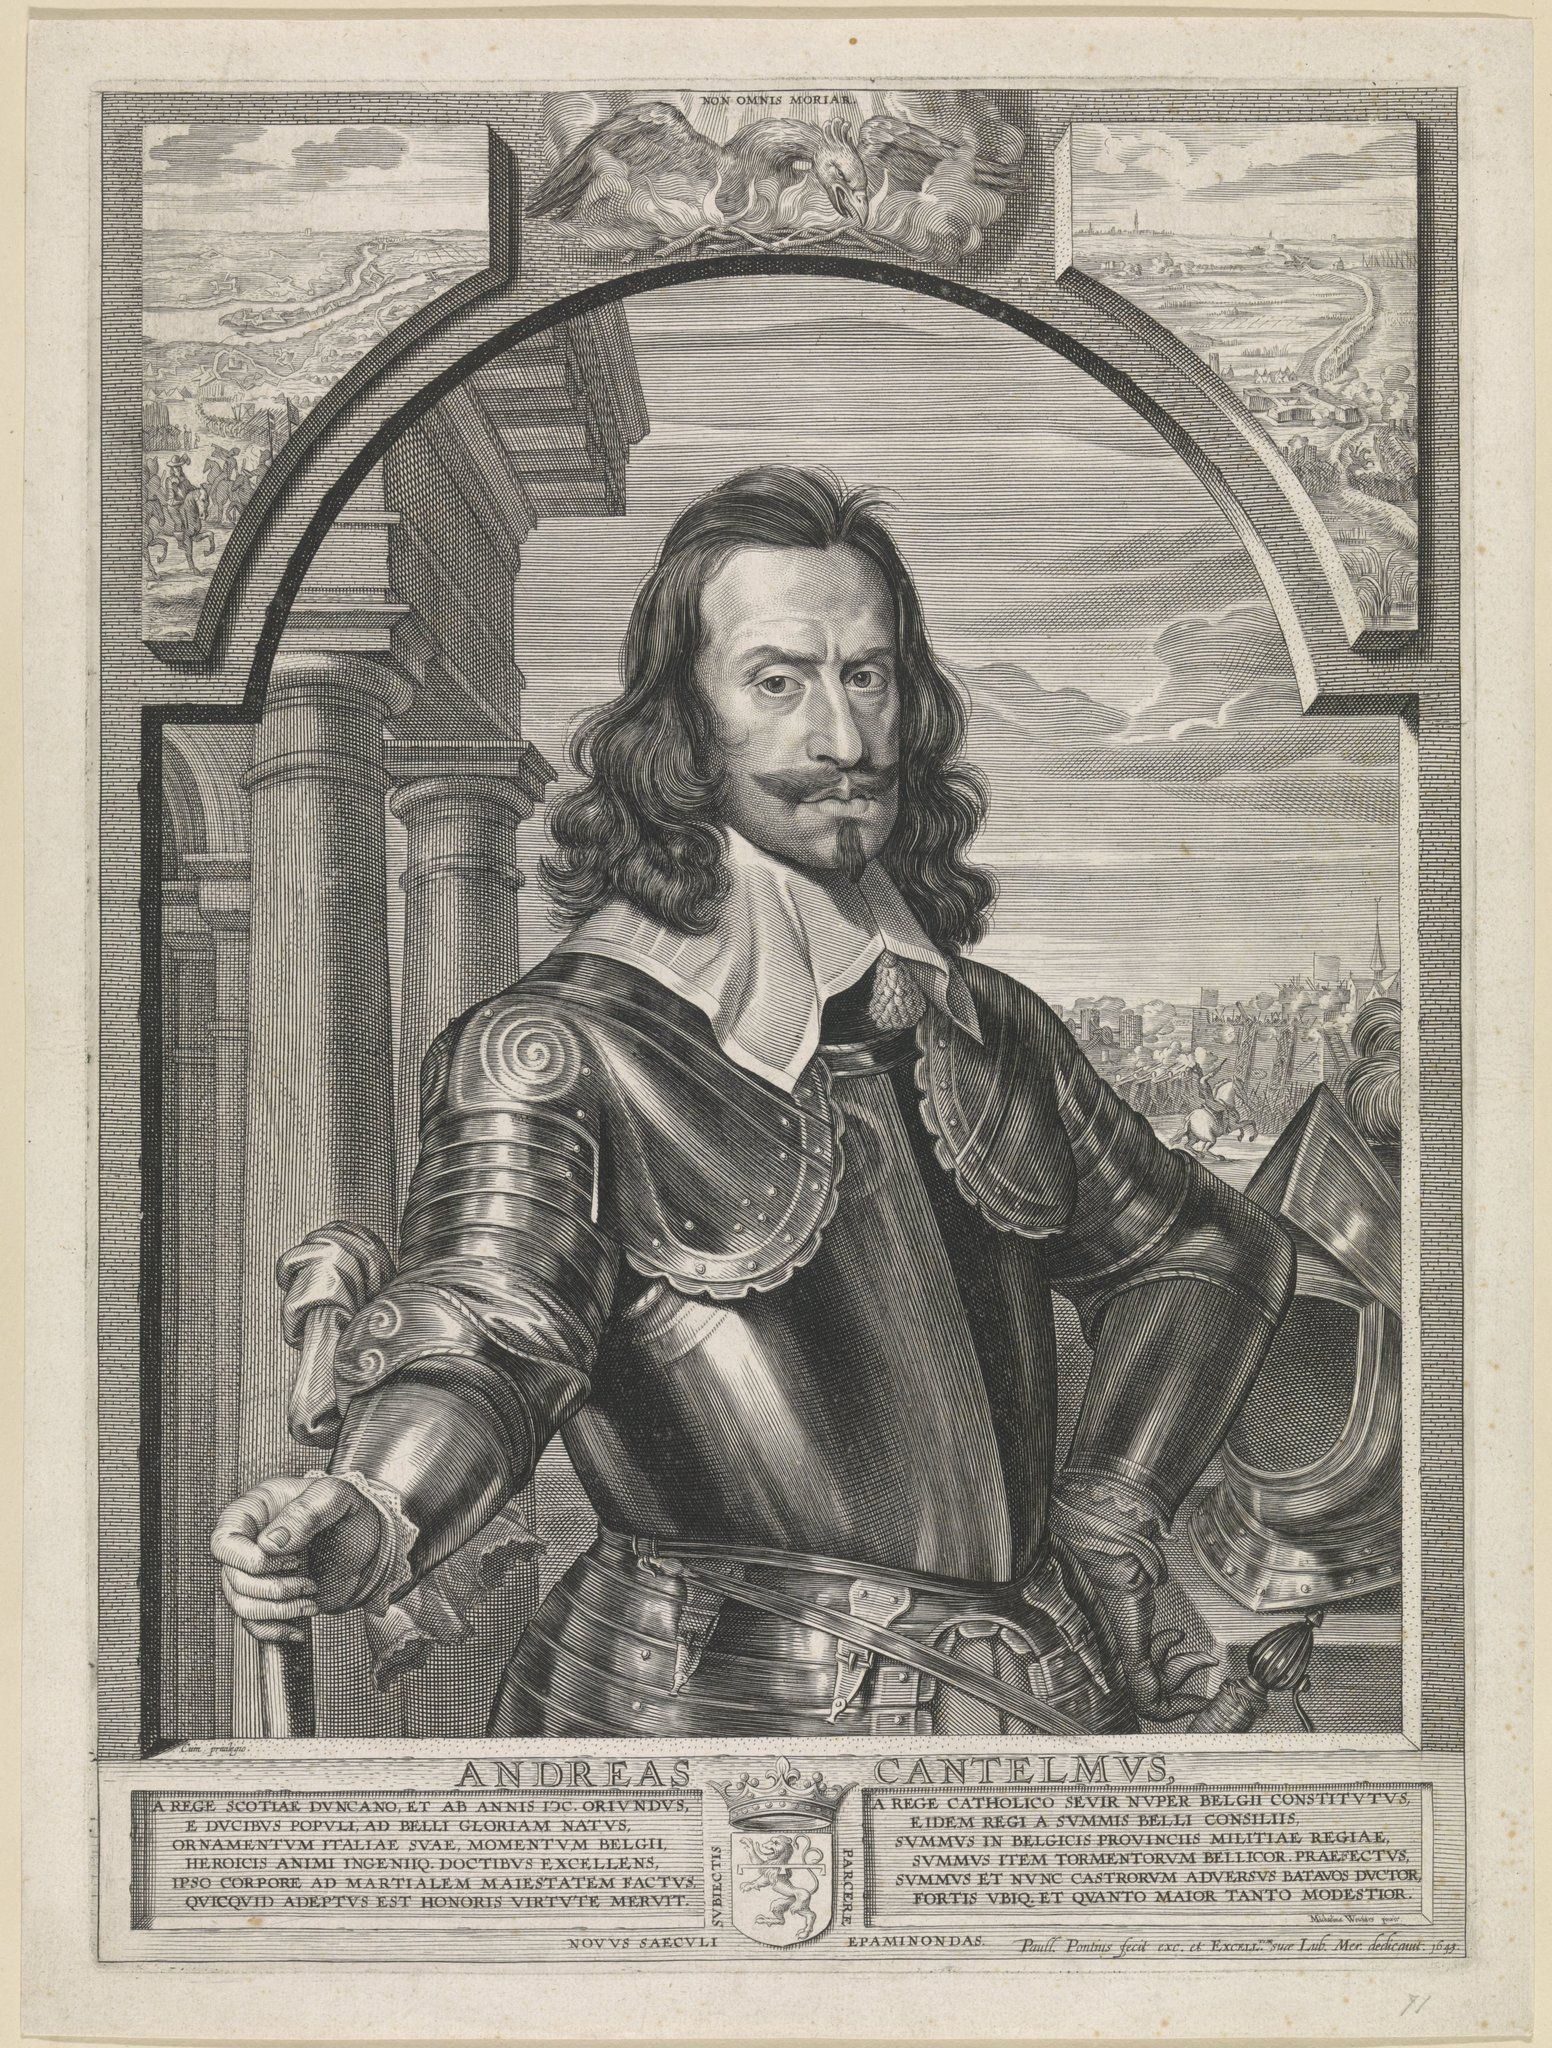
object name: print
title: Portret van Andrea Cantelmo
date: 1643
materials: paper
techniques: engraving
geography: antwerp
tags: don andrea cantelmo, predatory birds: eagle, armour, siege, armorial bearing, heraldry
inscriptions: inscription: ‘27 [...] E’, number: ‘120’, collector's mark: Lugt 240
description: Portret van de Italiaanse veldheer Andrea Cantelmo, hij was in dienst van het Spaanse leger in de Nederlanden. Op de achtergrond en in de bovenhoeken afbeeldingen van de slag bij Borgerhout op 4 september 1643. Boven de geportretteerde een adelaar.